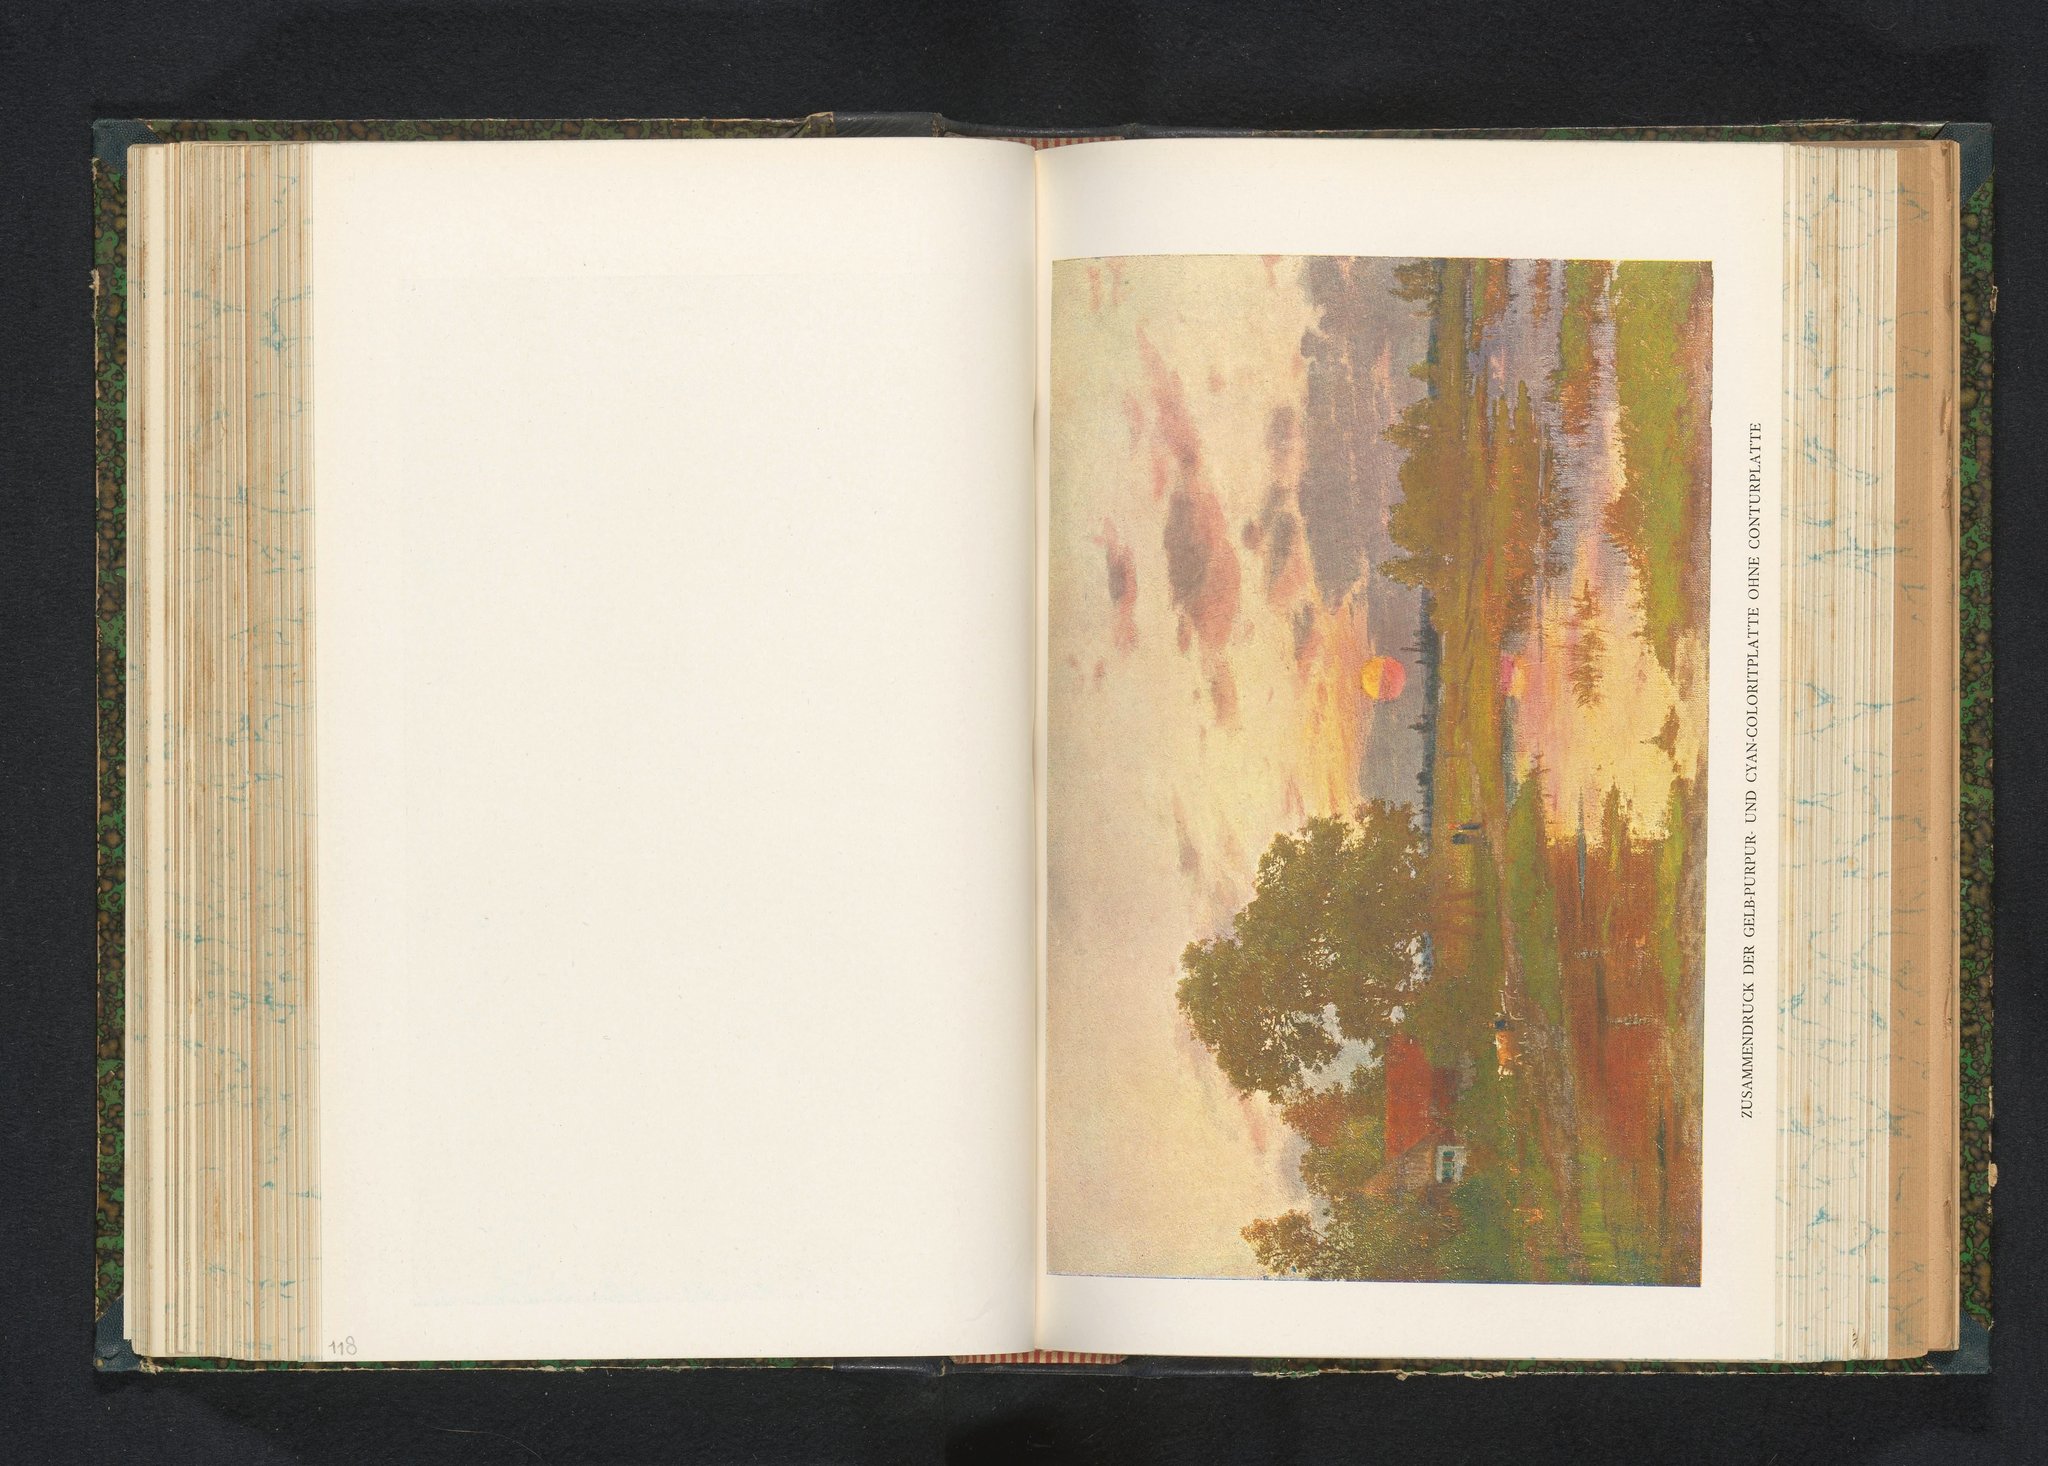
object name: photomechanical print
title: Zusammendruck der Gelb-Purpur- und Cyan-Coloritplatte ohne Conturplatte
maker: j. schoyrer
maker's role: fotograaf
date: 1894-1899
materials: paper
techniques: three-color autotype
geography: munich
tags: landscapes, sunset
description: Prent op tweede ongenummerde pagina na pagina 216.